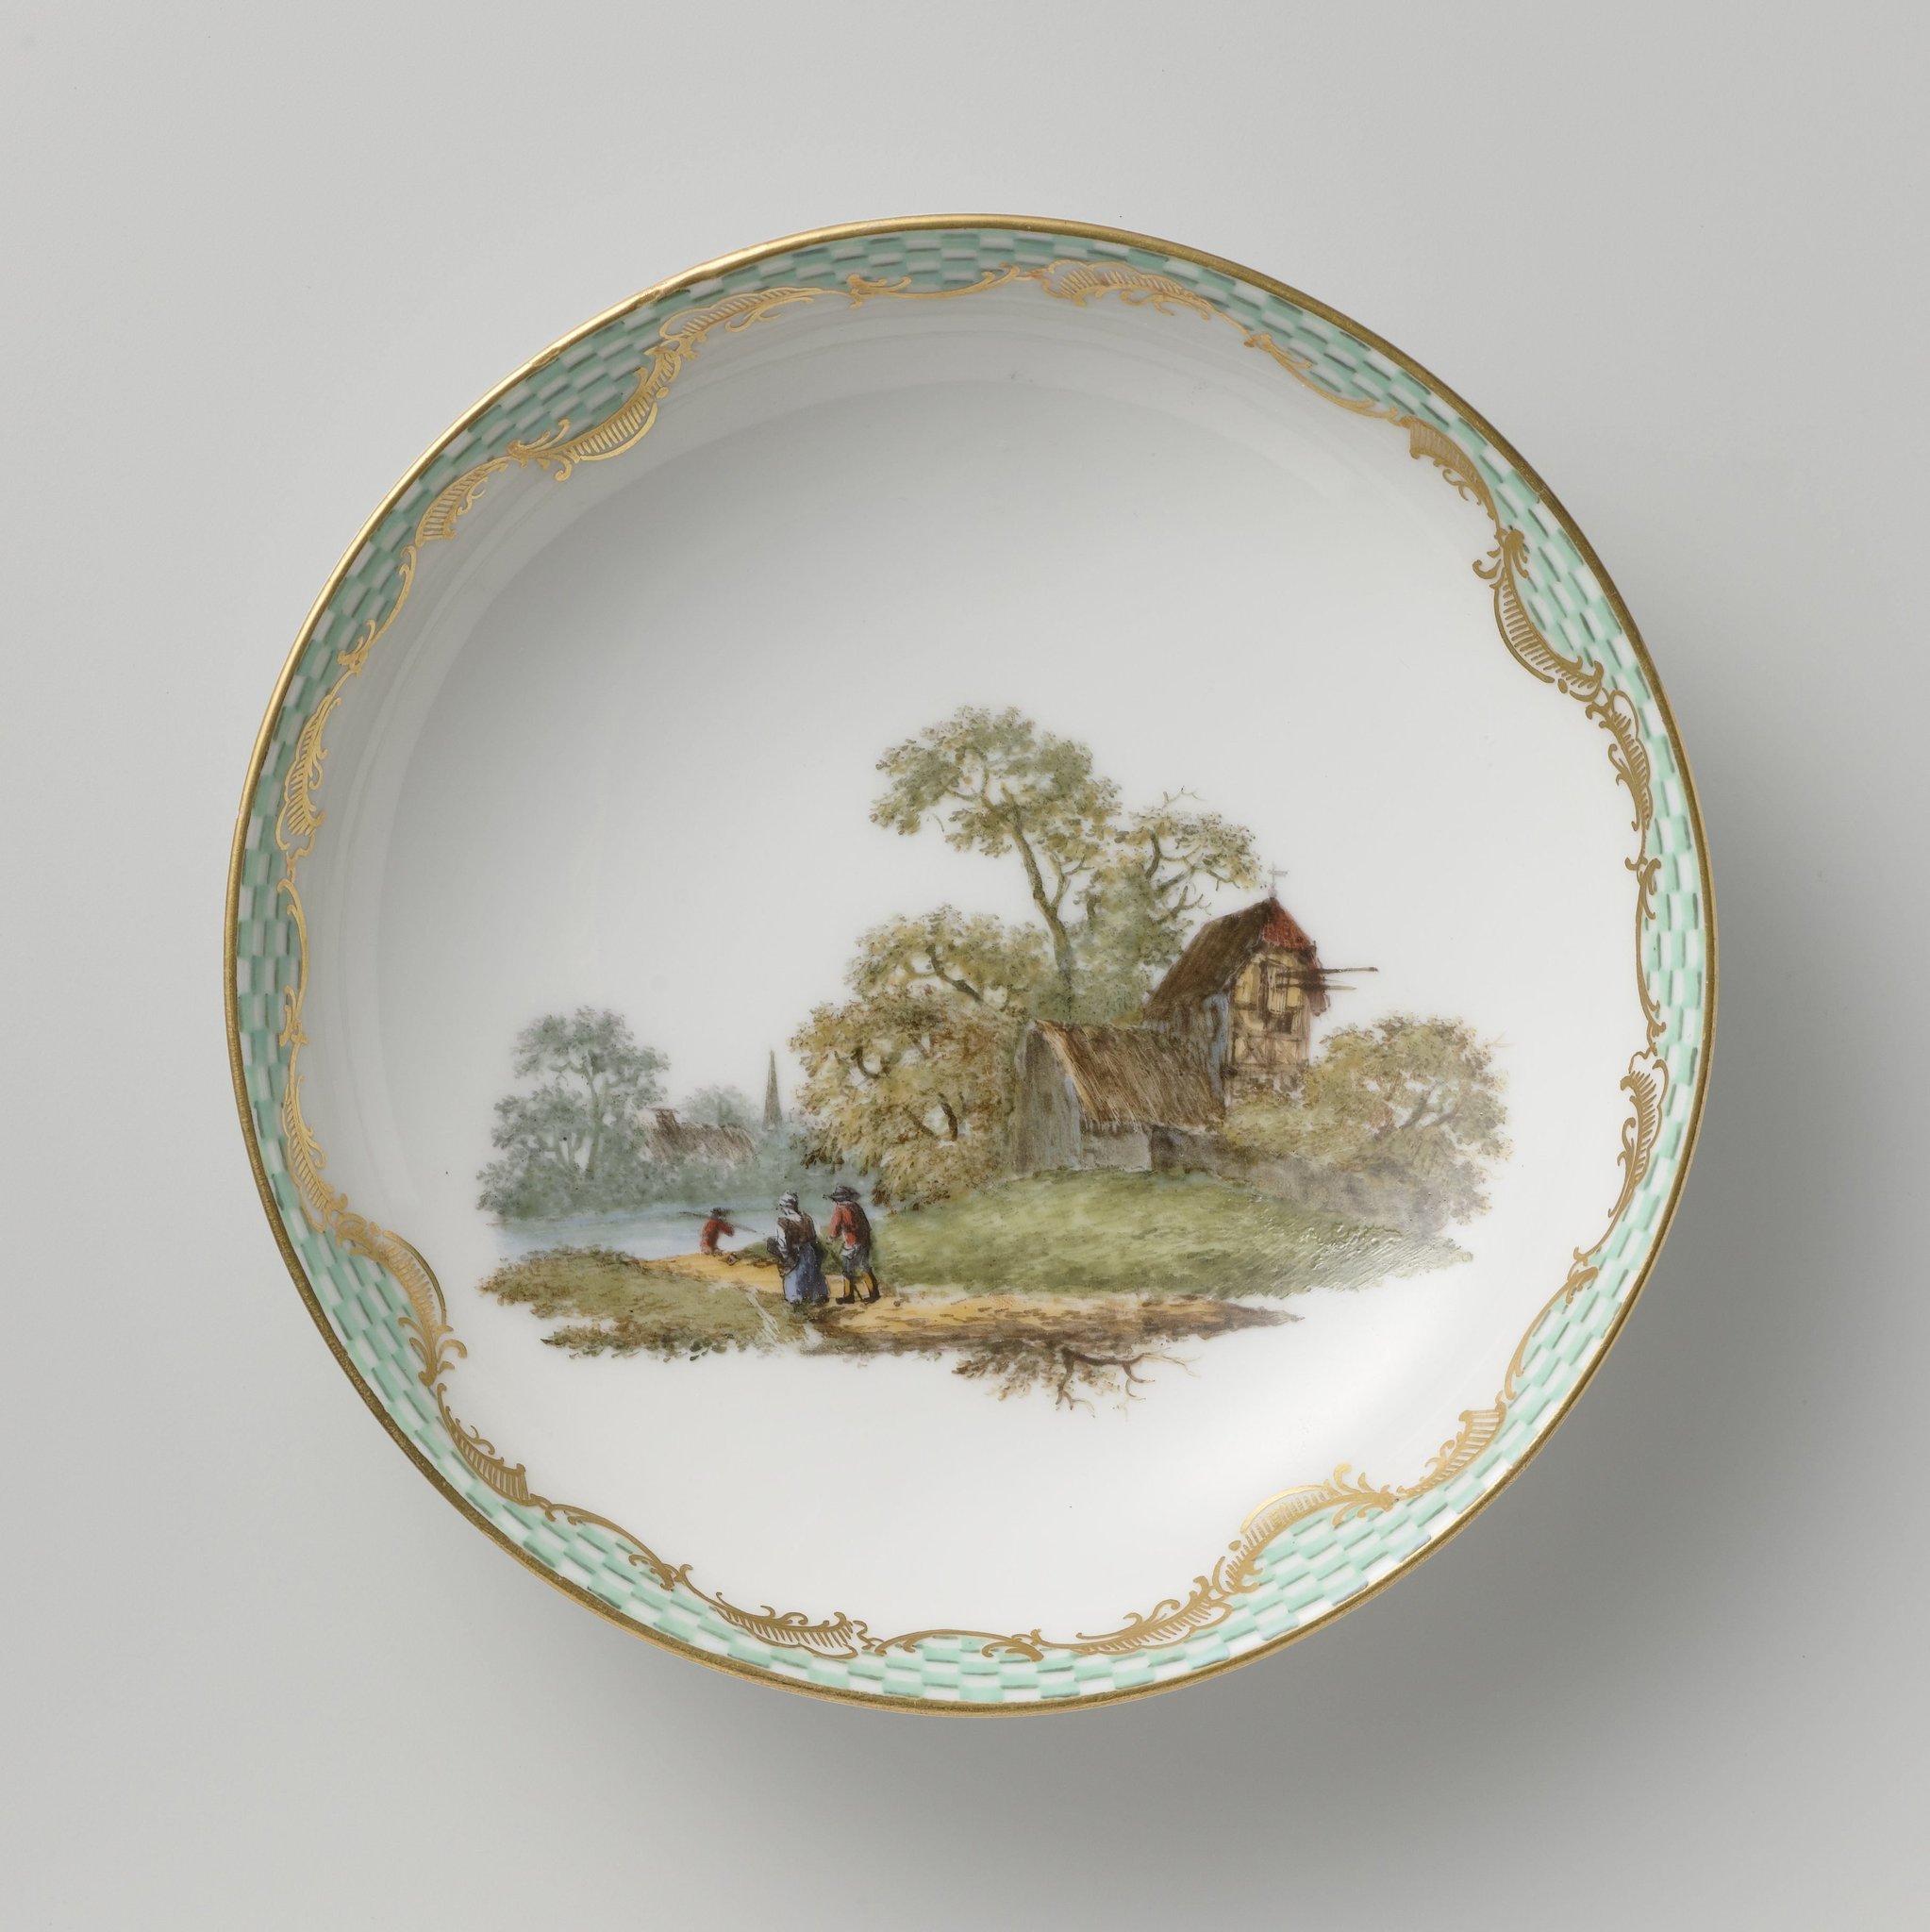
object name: platter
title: Schotel, veelkleurig beschilderd met een landschap met figuren.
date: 1777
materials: porcelain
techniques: painted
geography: meissen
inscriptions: factory mark, mold mark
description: Ronde schotel van beschilderd porselein. De schotel is beschilderd met landschappen waarin figuren en langs de rand een brede strook groen vlechtwerk. De schotel is gemerkt.